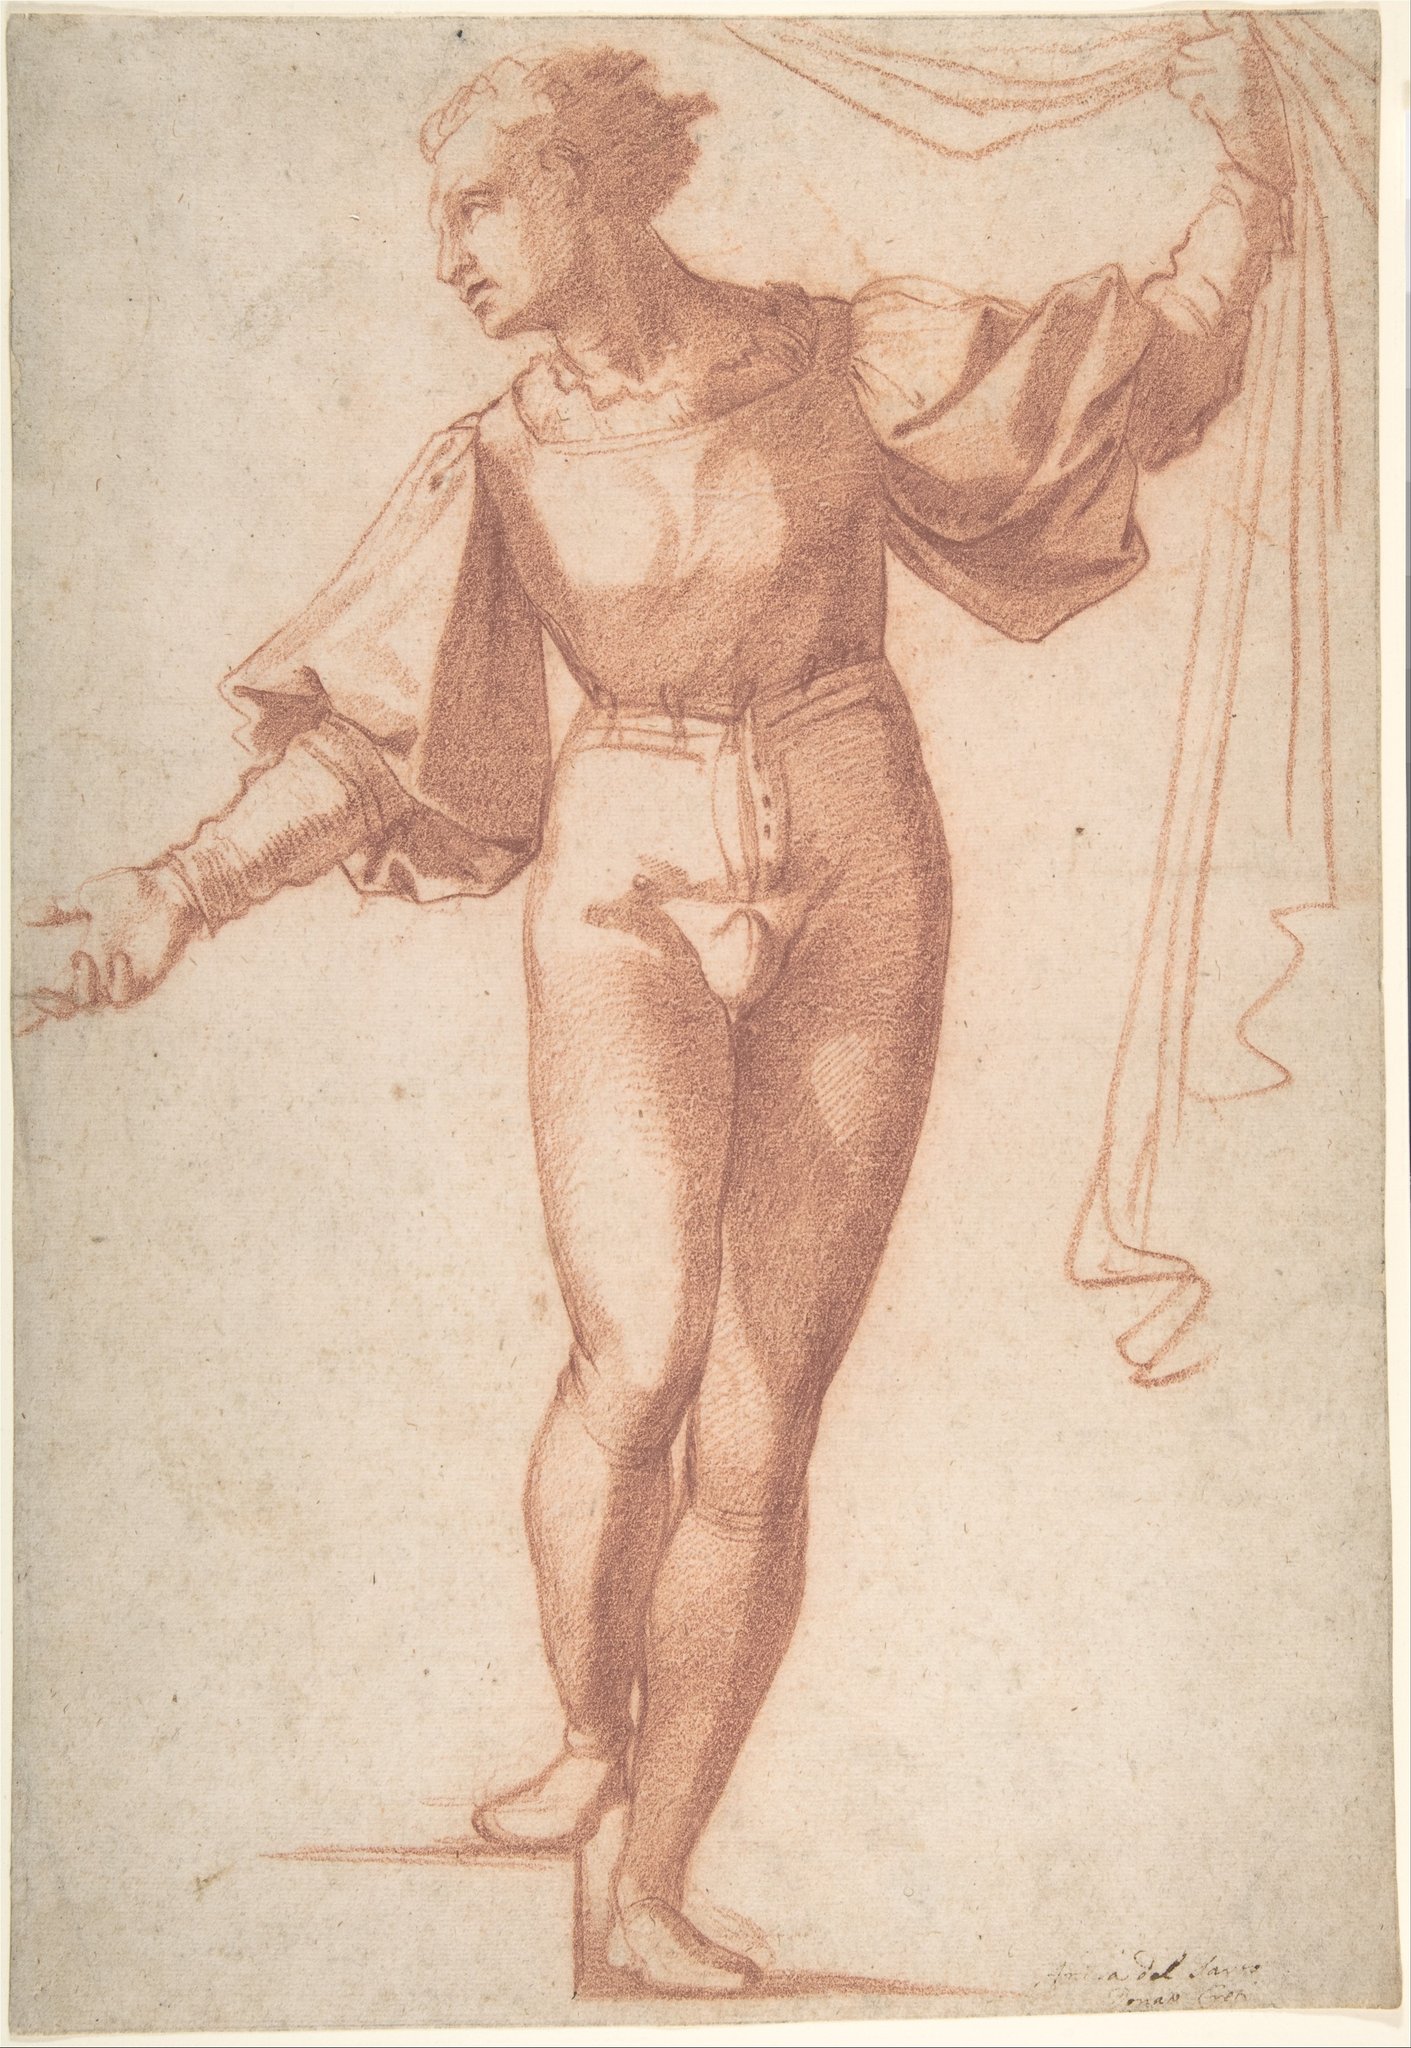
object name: drawing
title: Study for a Standing Young Man, Raising a Curtain and Looking at Left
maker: baccio bandinelli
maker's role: artist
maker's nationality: italian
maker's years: 1493-1560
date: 1518-1519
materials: chalk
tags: men